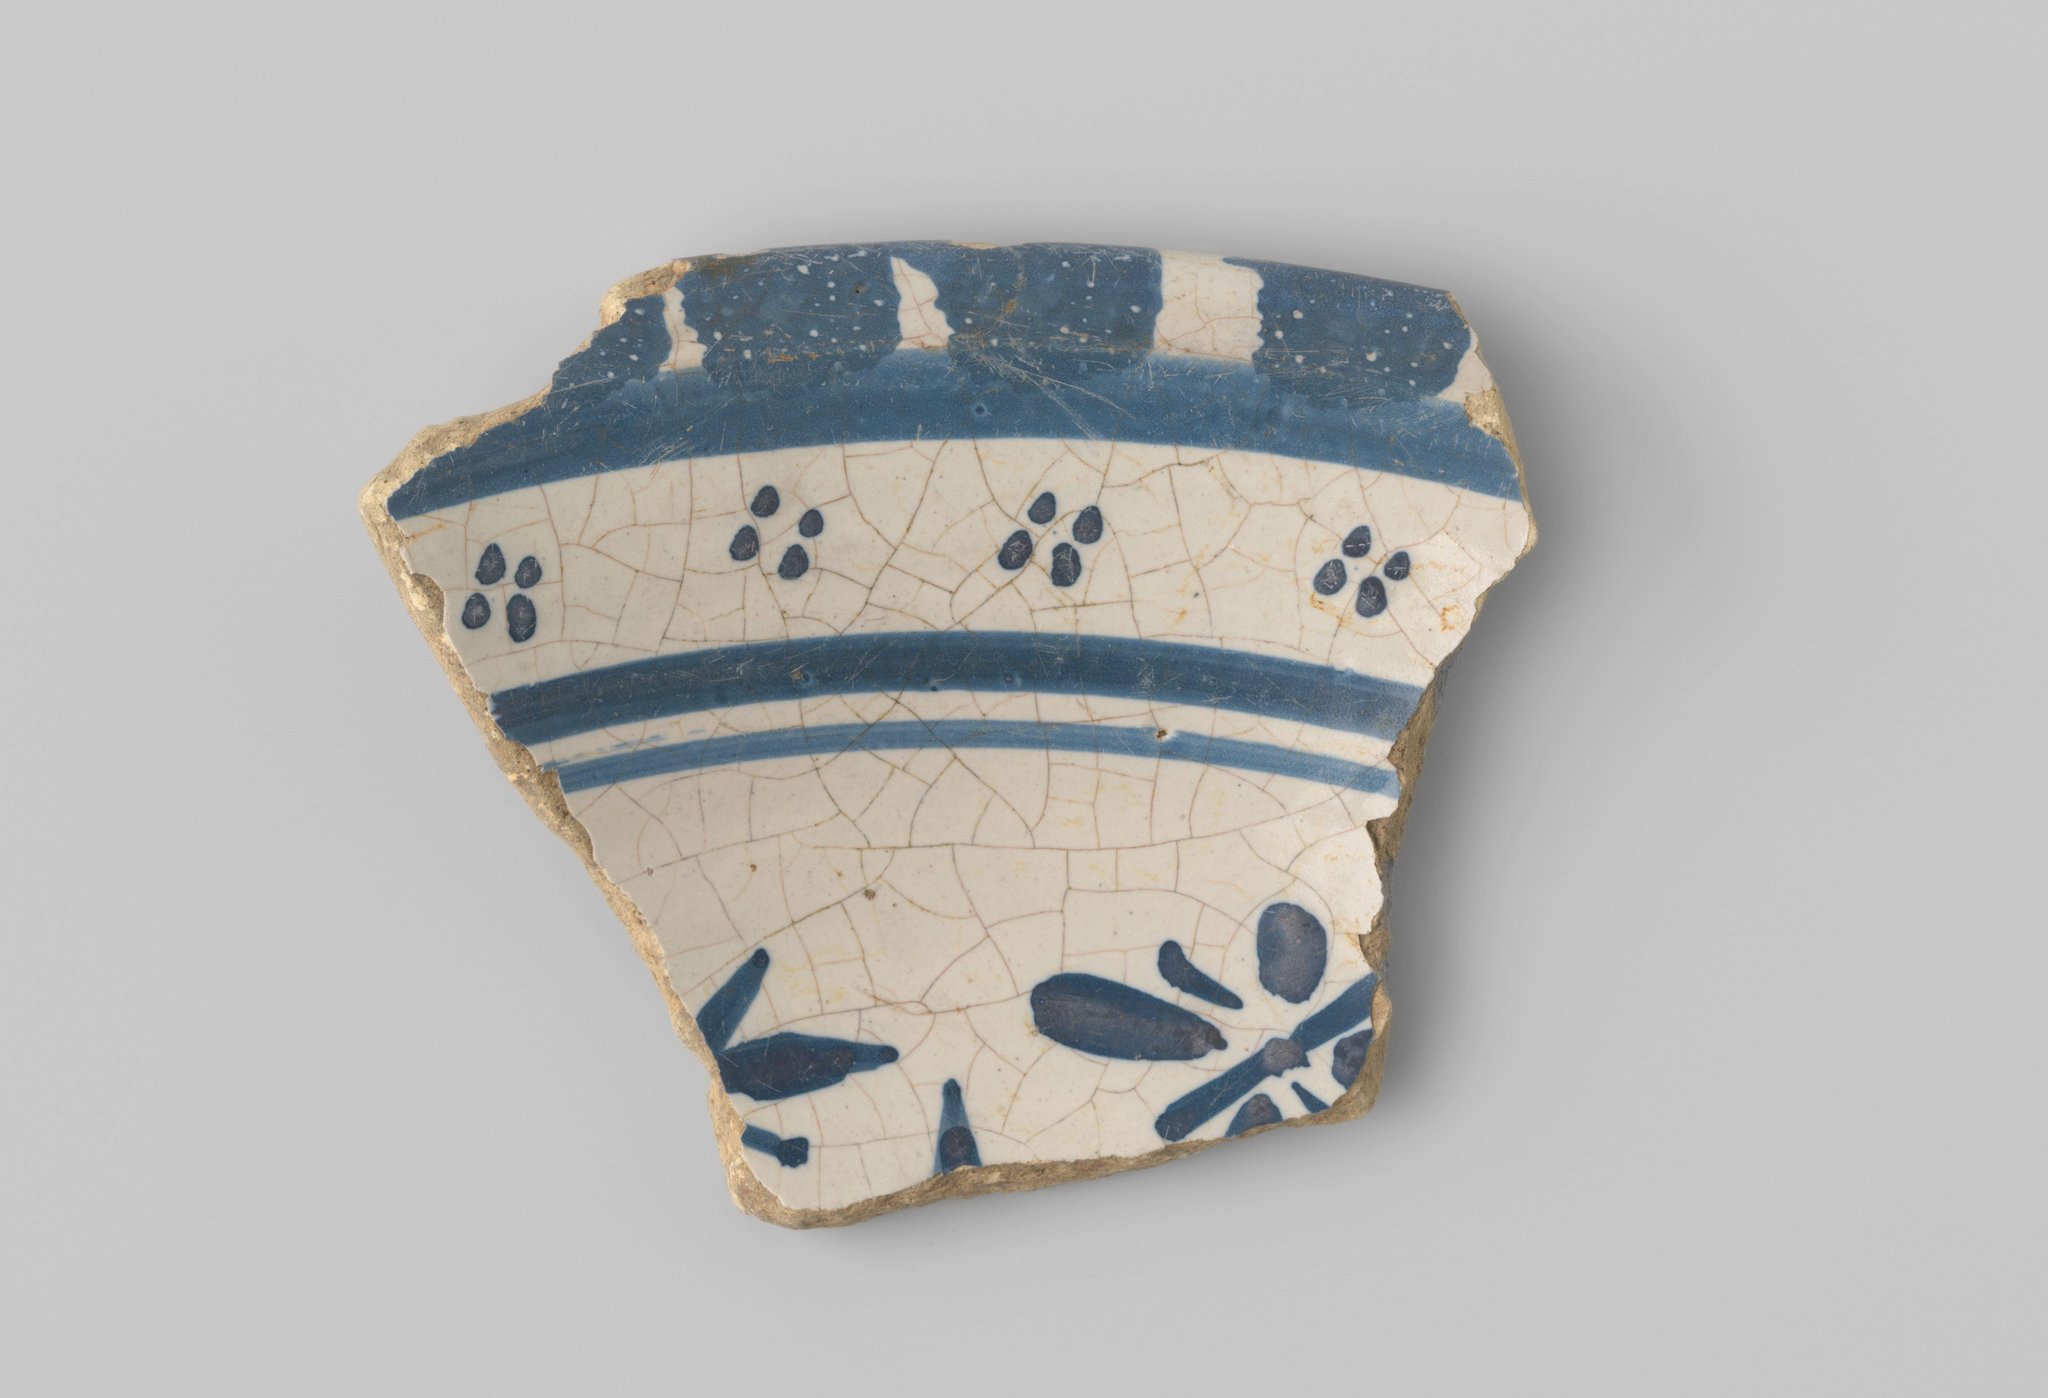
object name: sherd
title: Scherf van witbakkend aardewerk, aan de bovenzijde voorzien van een beschildering in blauw op een witte ondergrond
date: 1500-1899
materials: earthenware, glaze